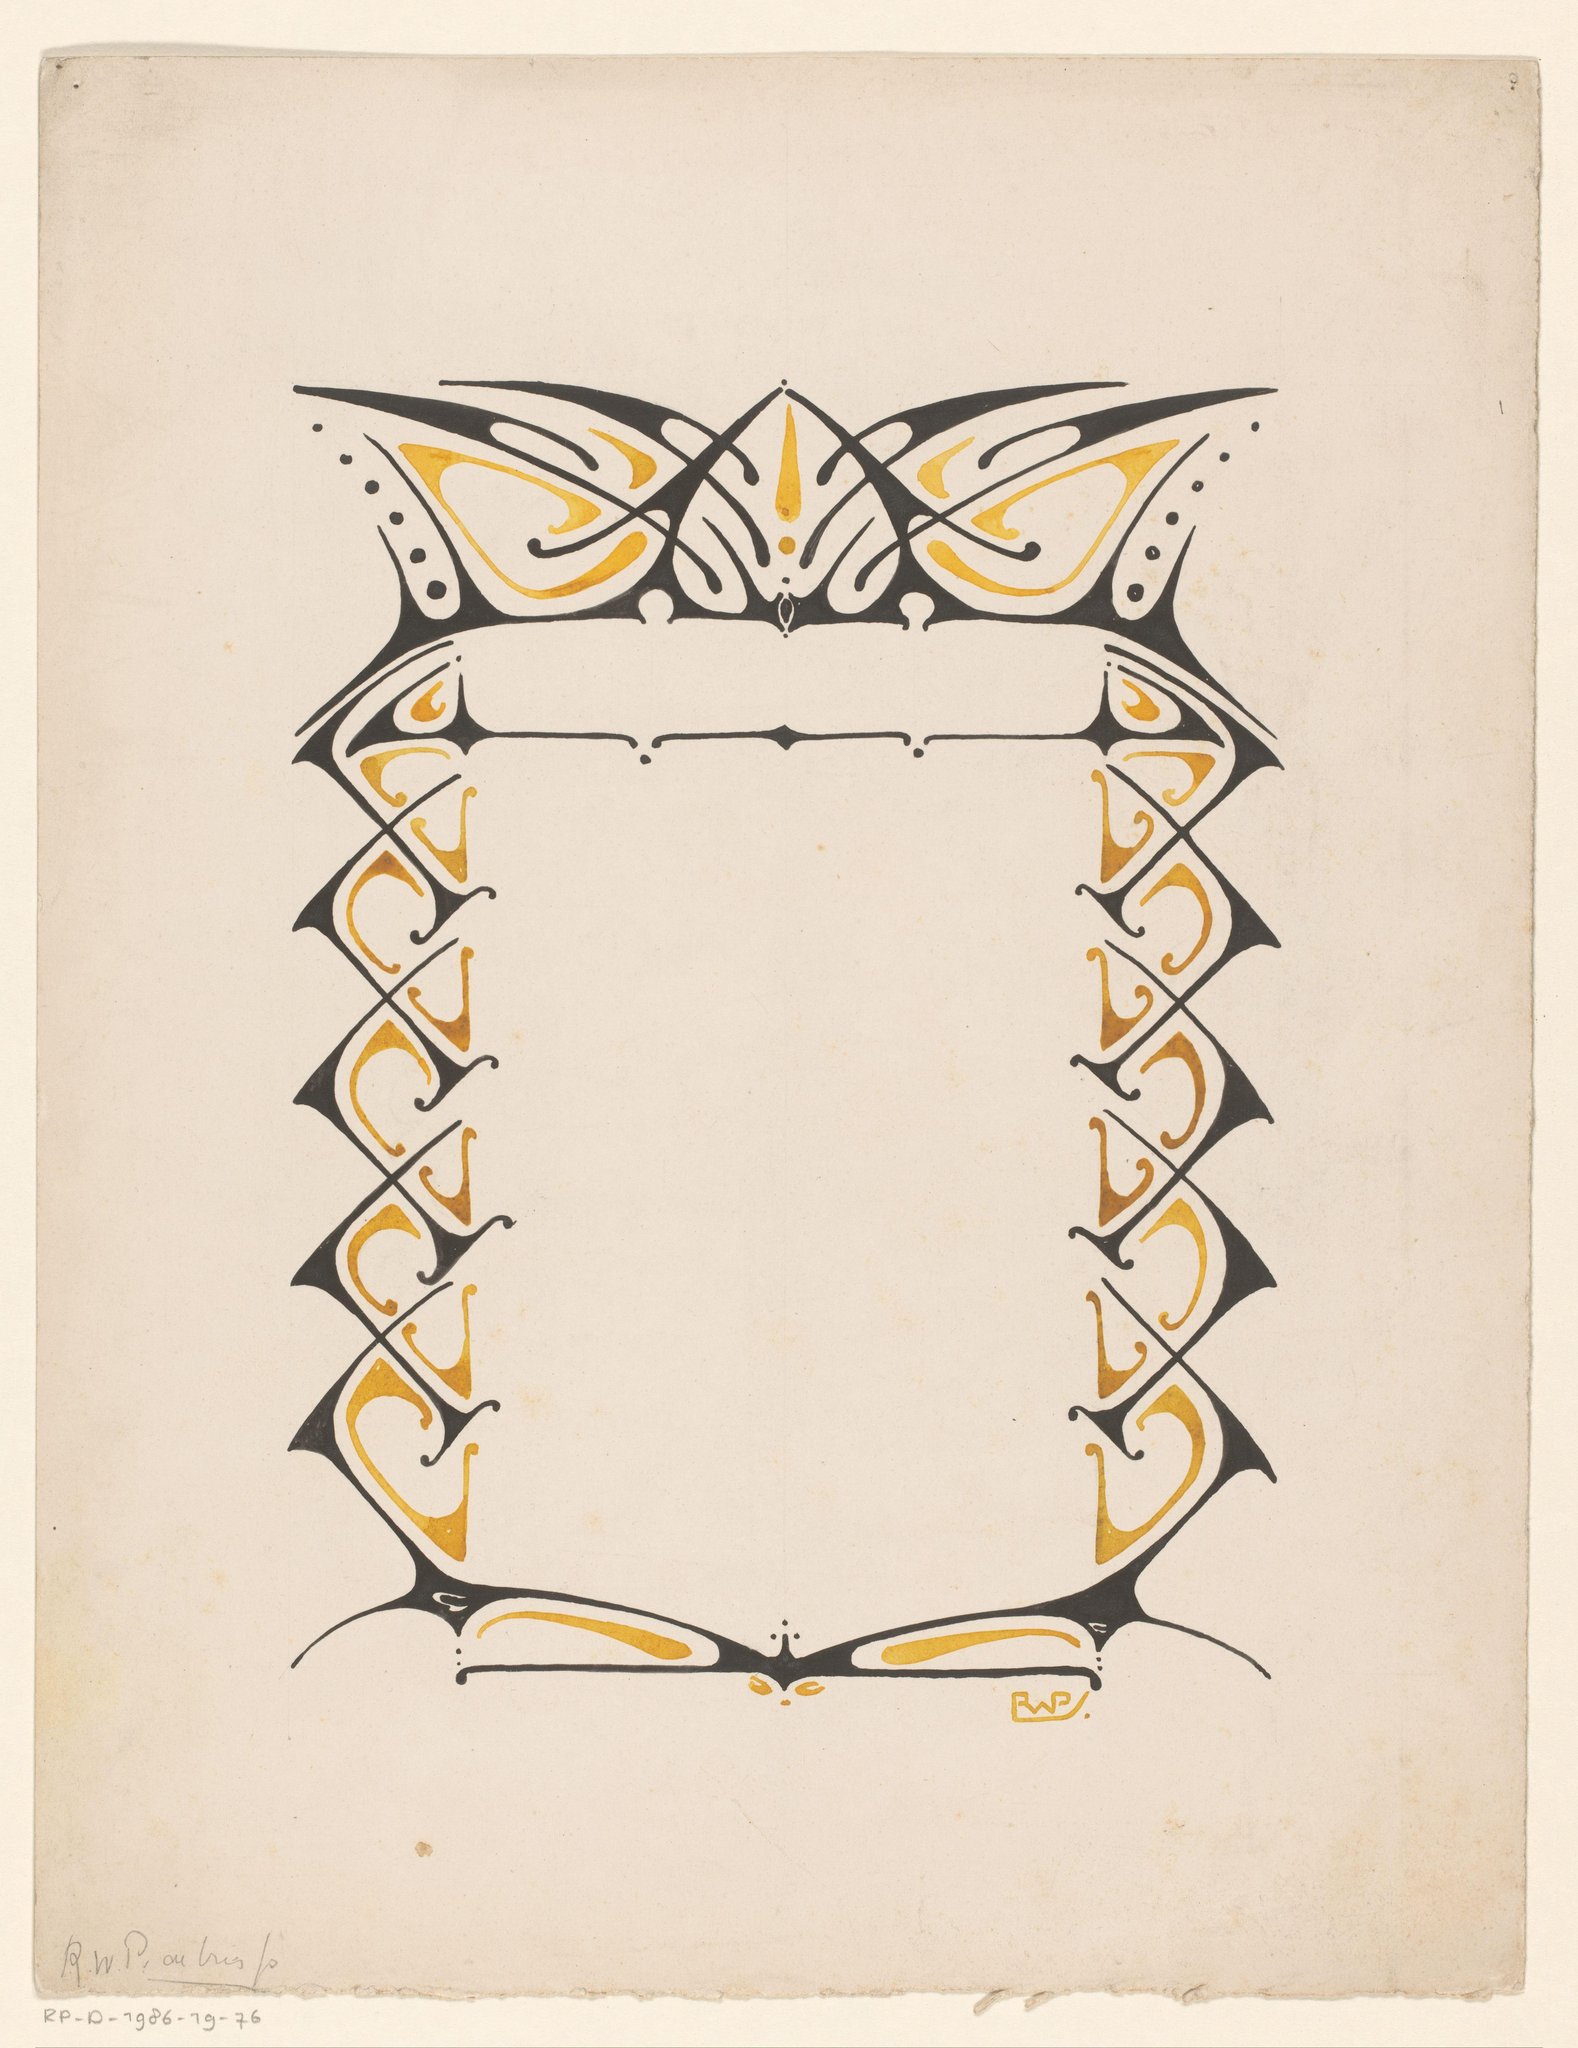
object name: drawing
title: Kader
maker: reinier willem petrus de vries (1874-1953)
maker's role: draughtsman, print maker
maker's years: 1874-1953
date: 1884-1952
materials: ink, paper, watercolor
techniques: brush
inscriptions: collector's mark: ‘R:MVS.’, name: ‘R.W.P. de Vries jr’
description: Rechthoekig kader met elkaar overlappende lijnen.